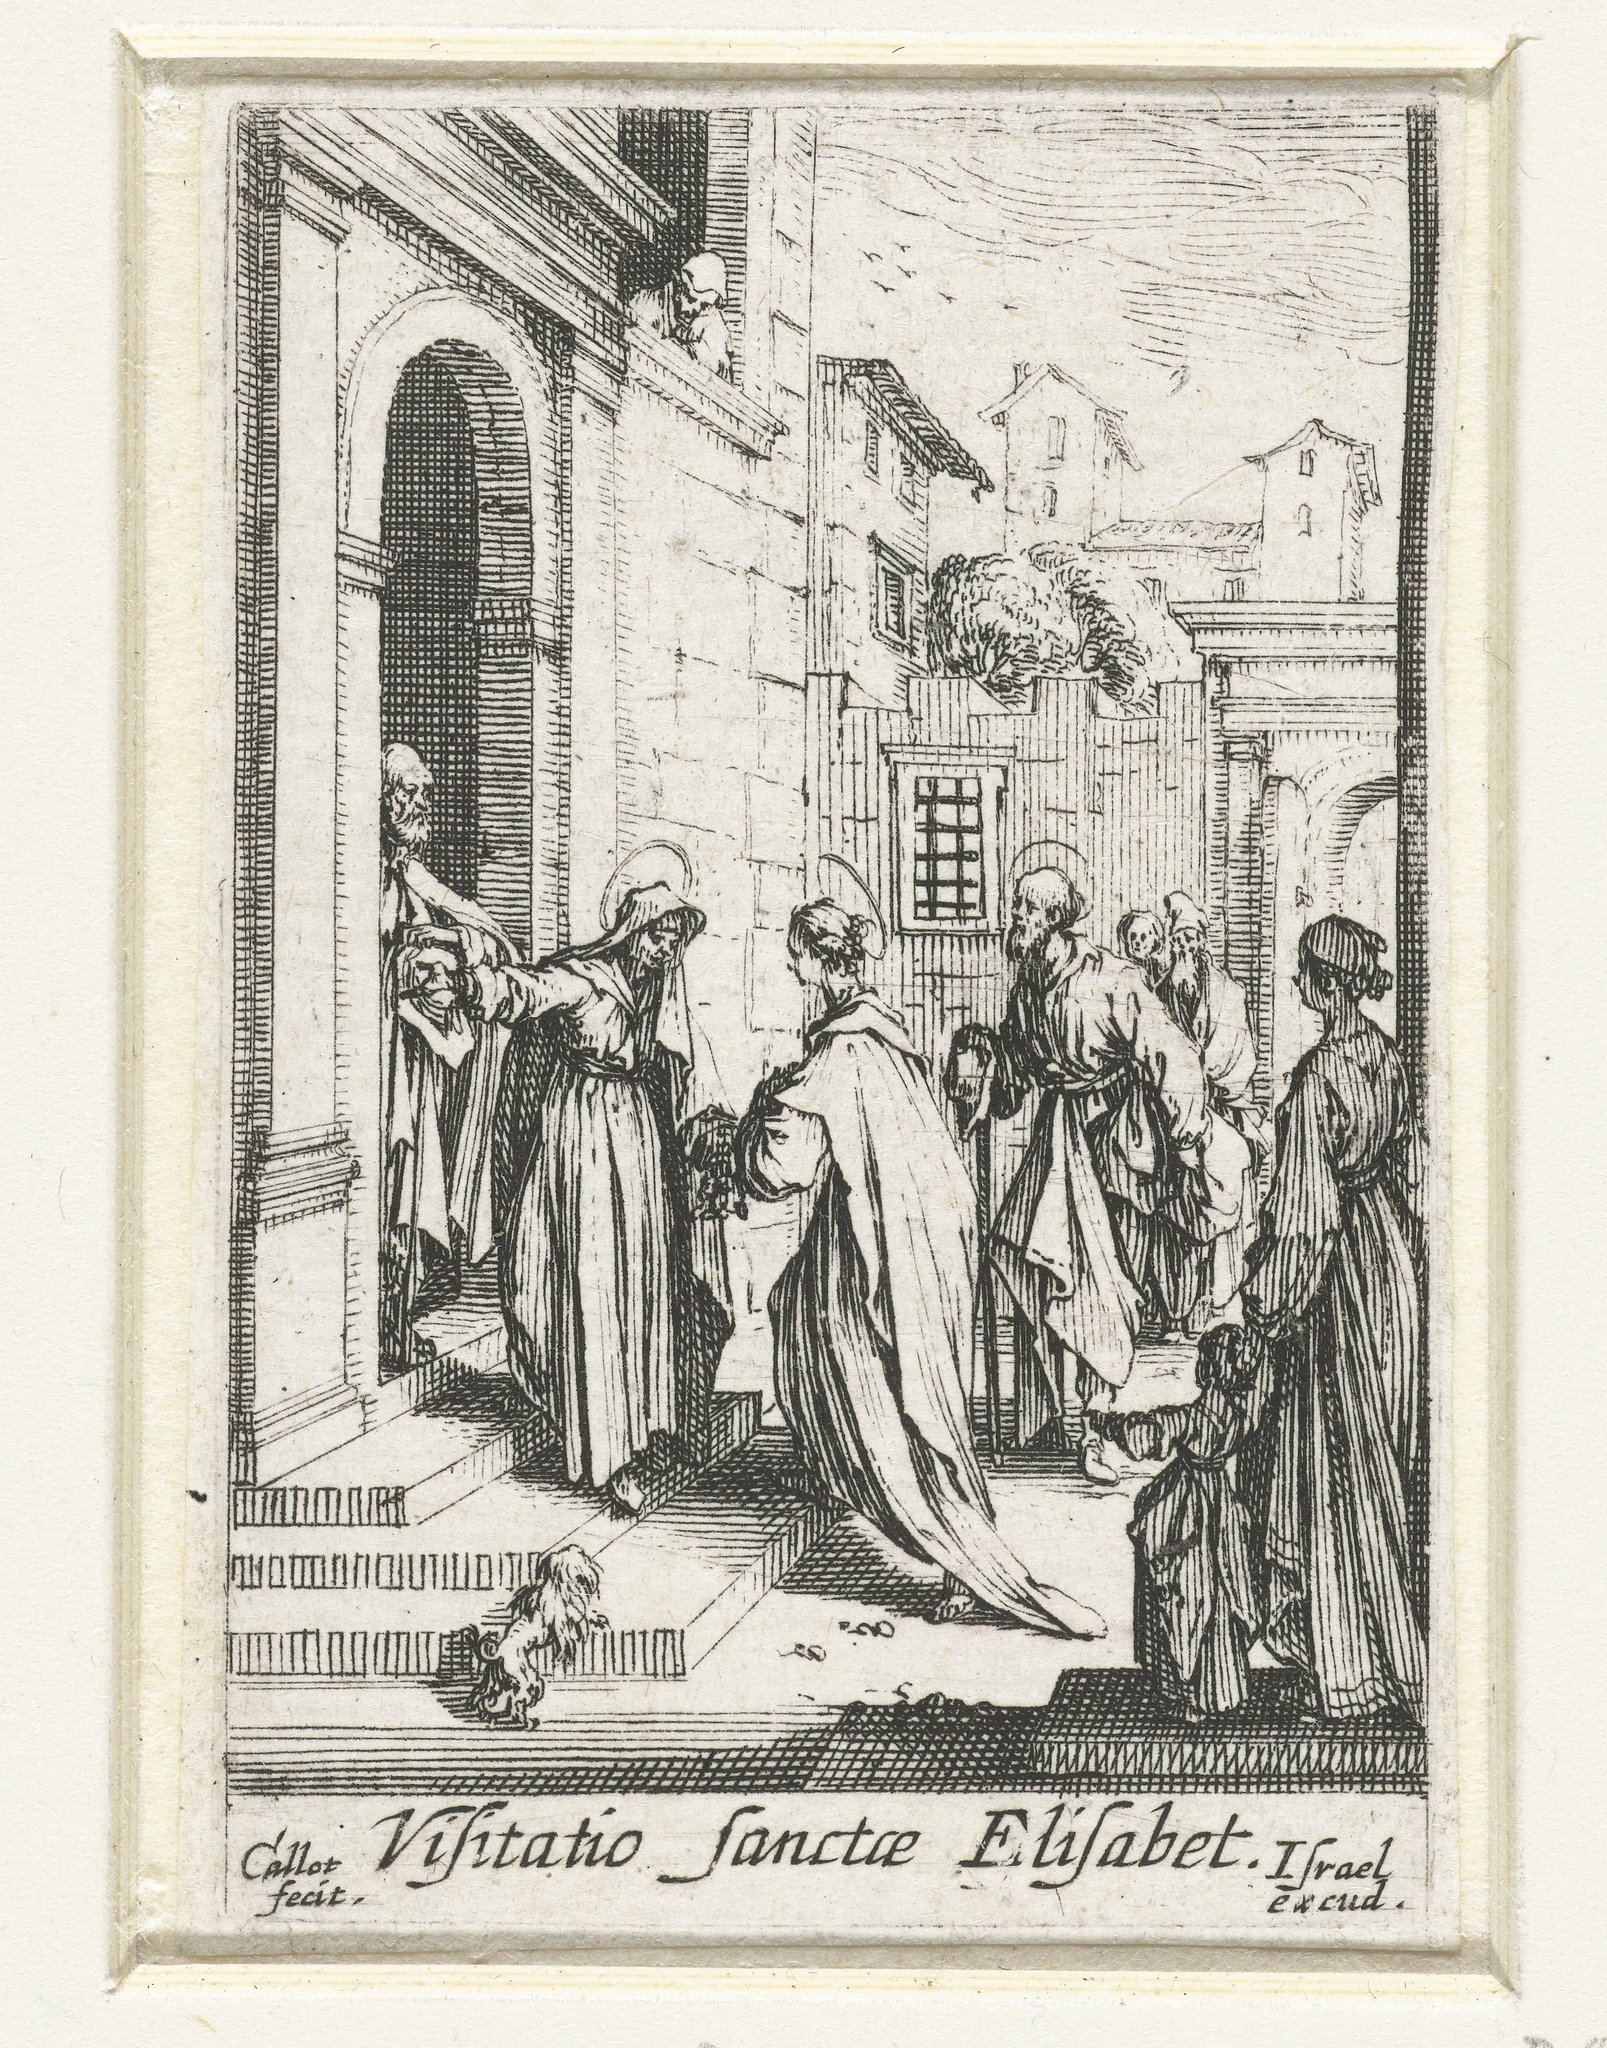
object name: print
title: Leven van Maria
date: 1633-1634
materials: paper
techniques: etching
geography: paris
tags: visitation (possibly joseph and/or zacharias present) (luke 1:39-56)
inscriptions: collector's mark: Lugt 240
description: Maria en Elizabeth, beiden net zwanger, ontmoeten elkaar bij een huis. Zacharias staat in de deuropening, Jozef staat achter Maria. Onder de voorstelling een onderschrift in Latijn. Deze prent is onderdeel van een reeks prenten rond het leven van Maria, bestaande uit een titelprent en dertien verhalende voorstellingen.